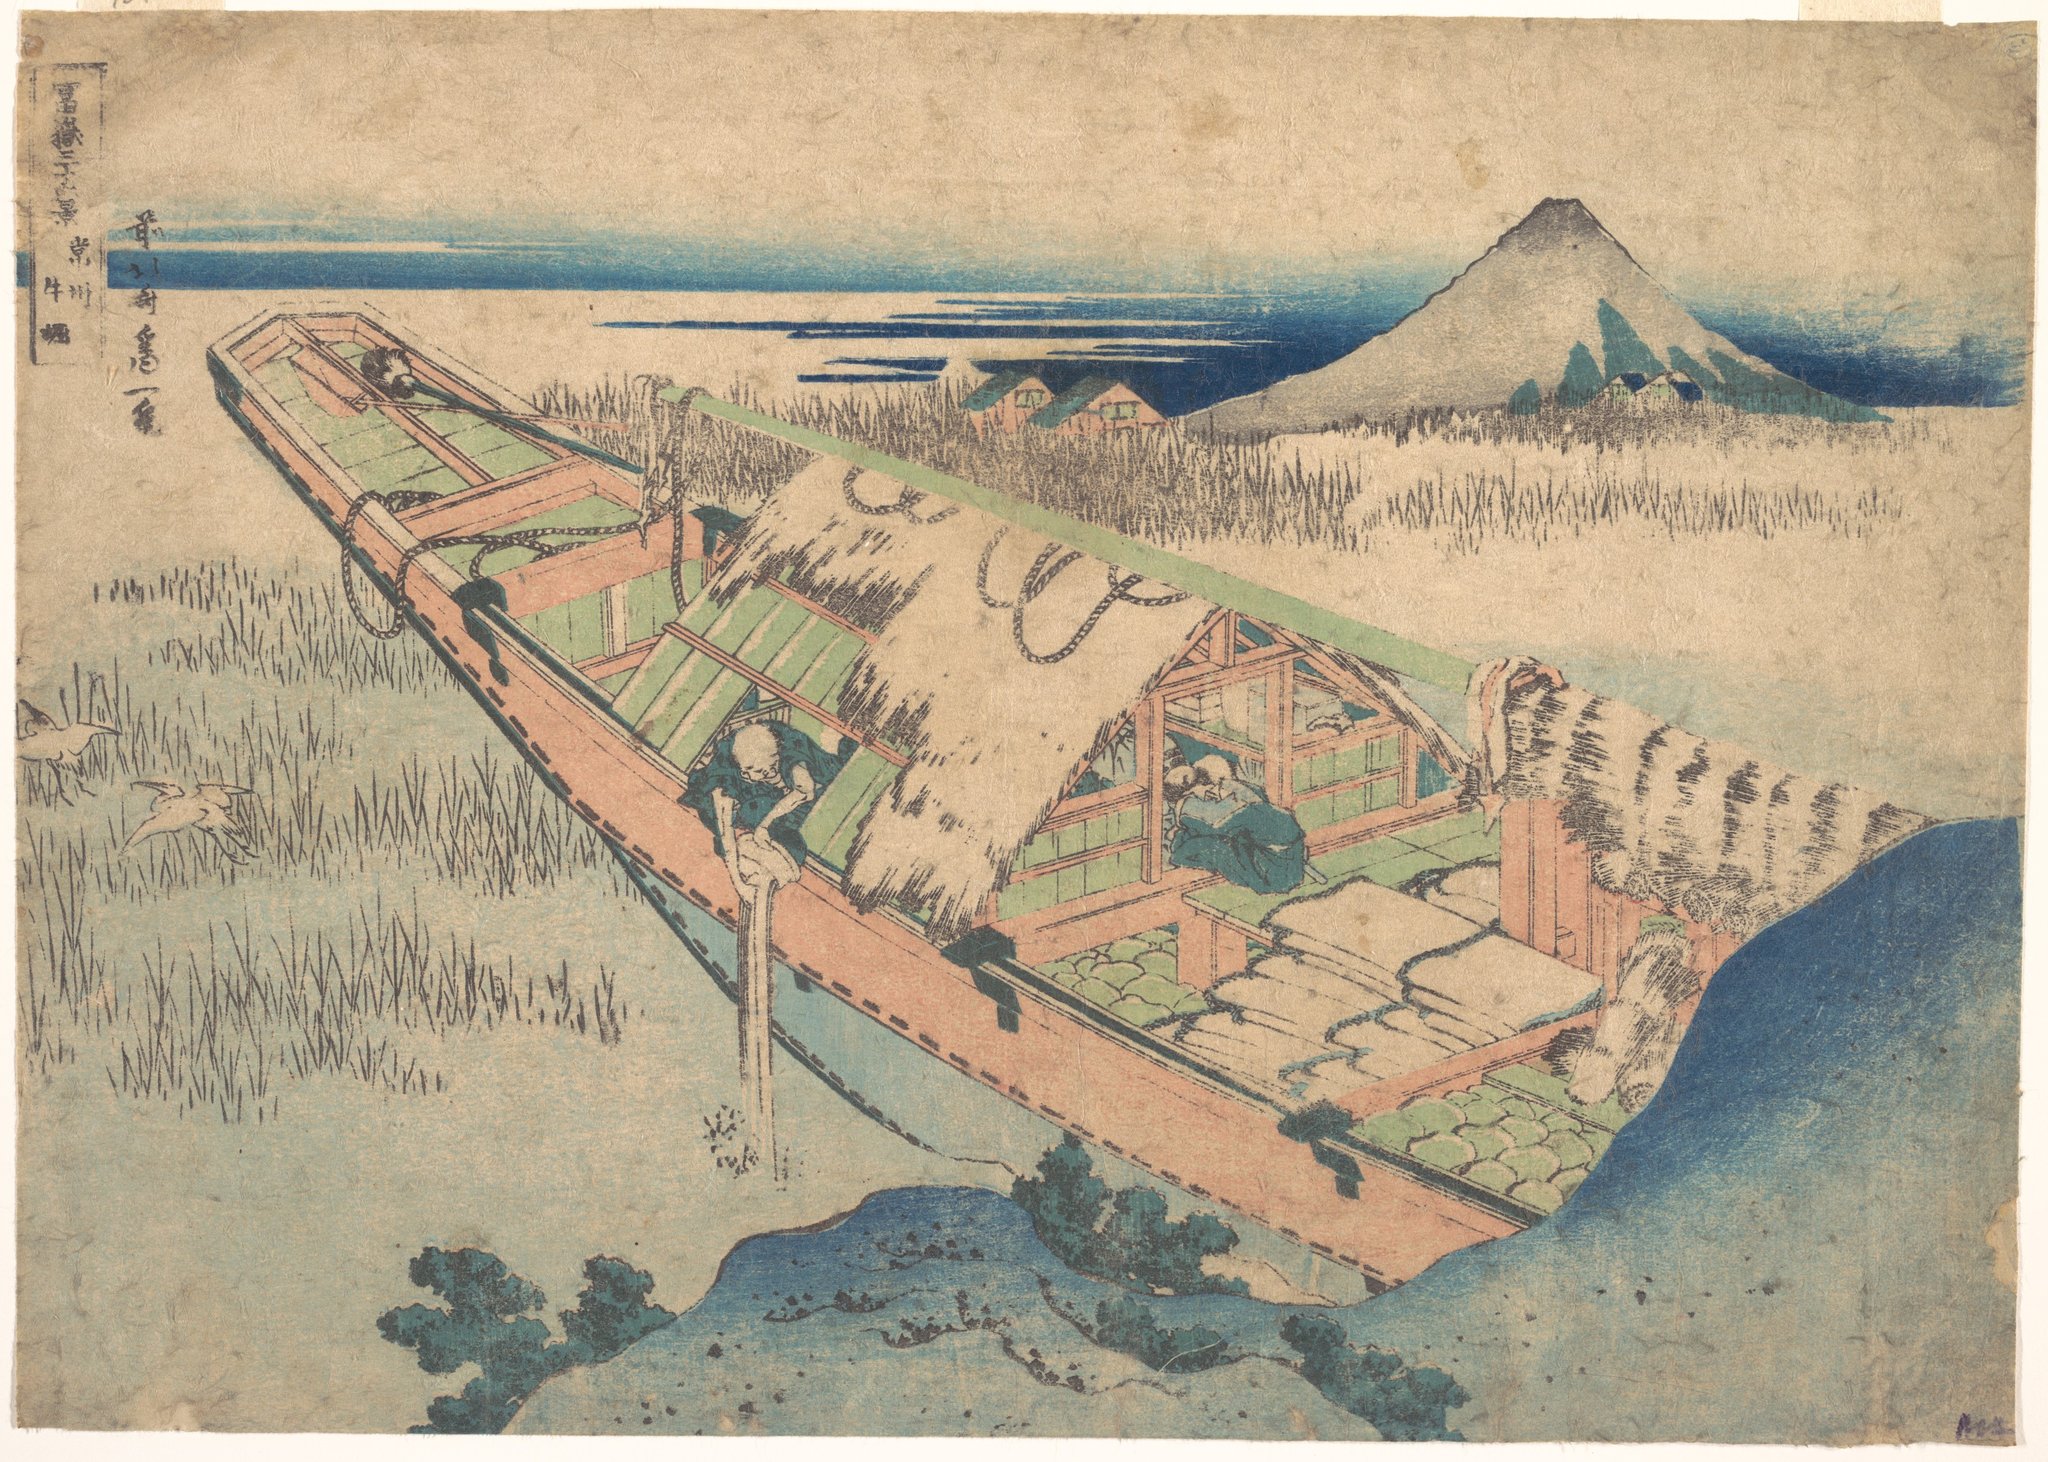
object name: woodblock print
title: Ushibori in Hitachi Province (Jōshū Ushibori), from the series Thirty-six Views of Mount Fuji (Fugaku sanjūrokkei)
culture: japanese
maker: katsushika hokusai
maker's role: artist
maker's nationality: japanese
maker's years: 1760-1849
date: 1830-1832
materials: ink, paper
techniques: woodblock print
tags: human figures,mountains,boats